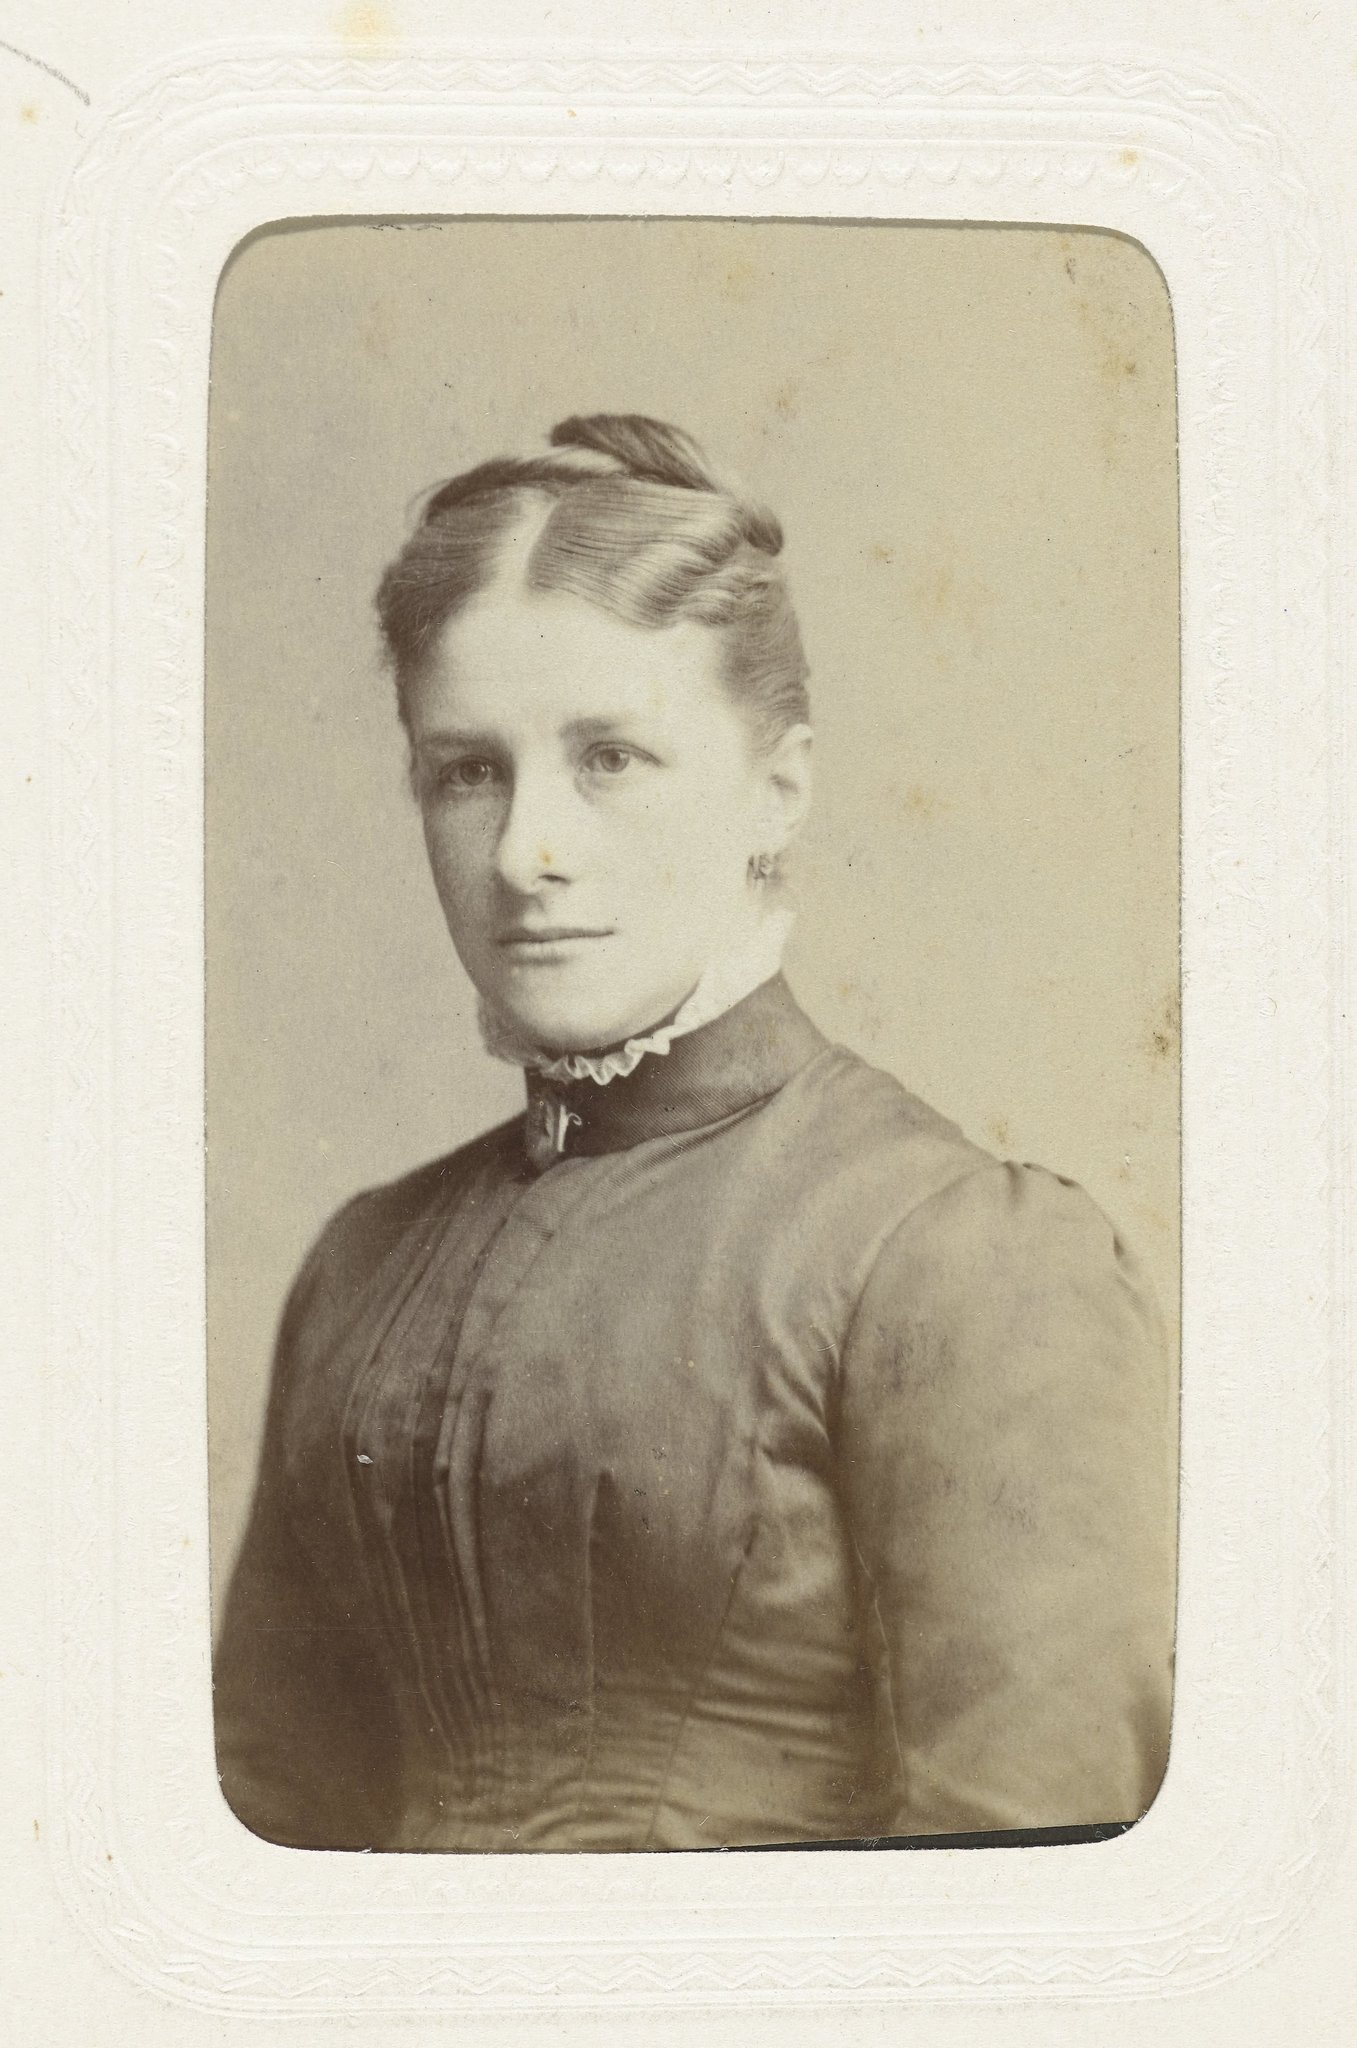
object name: carte de visite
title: Studioportret van een vrouw met opgestoken haar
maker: albert greiner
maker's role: fotograaf, fotostudio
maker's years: 1833-1890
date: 1863-1866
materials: cardboard, paper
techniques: albumen print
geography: amsterdam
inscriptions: name: ‘Albert Greiner, Amsterdam’